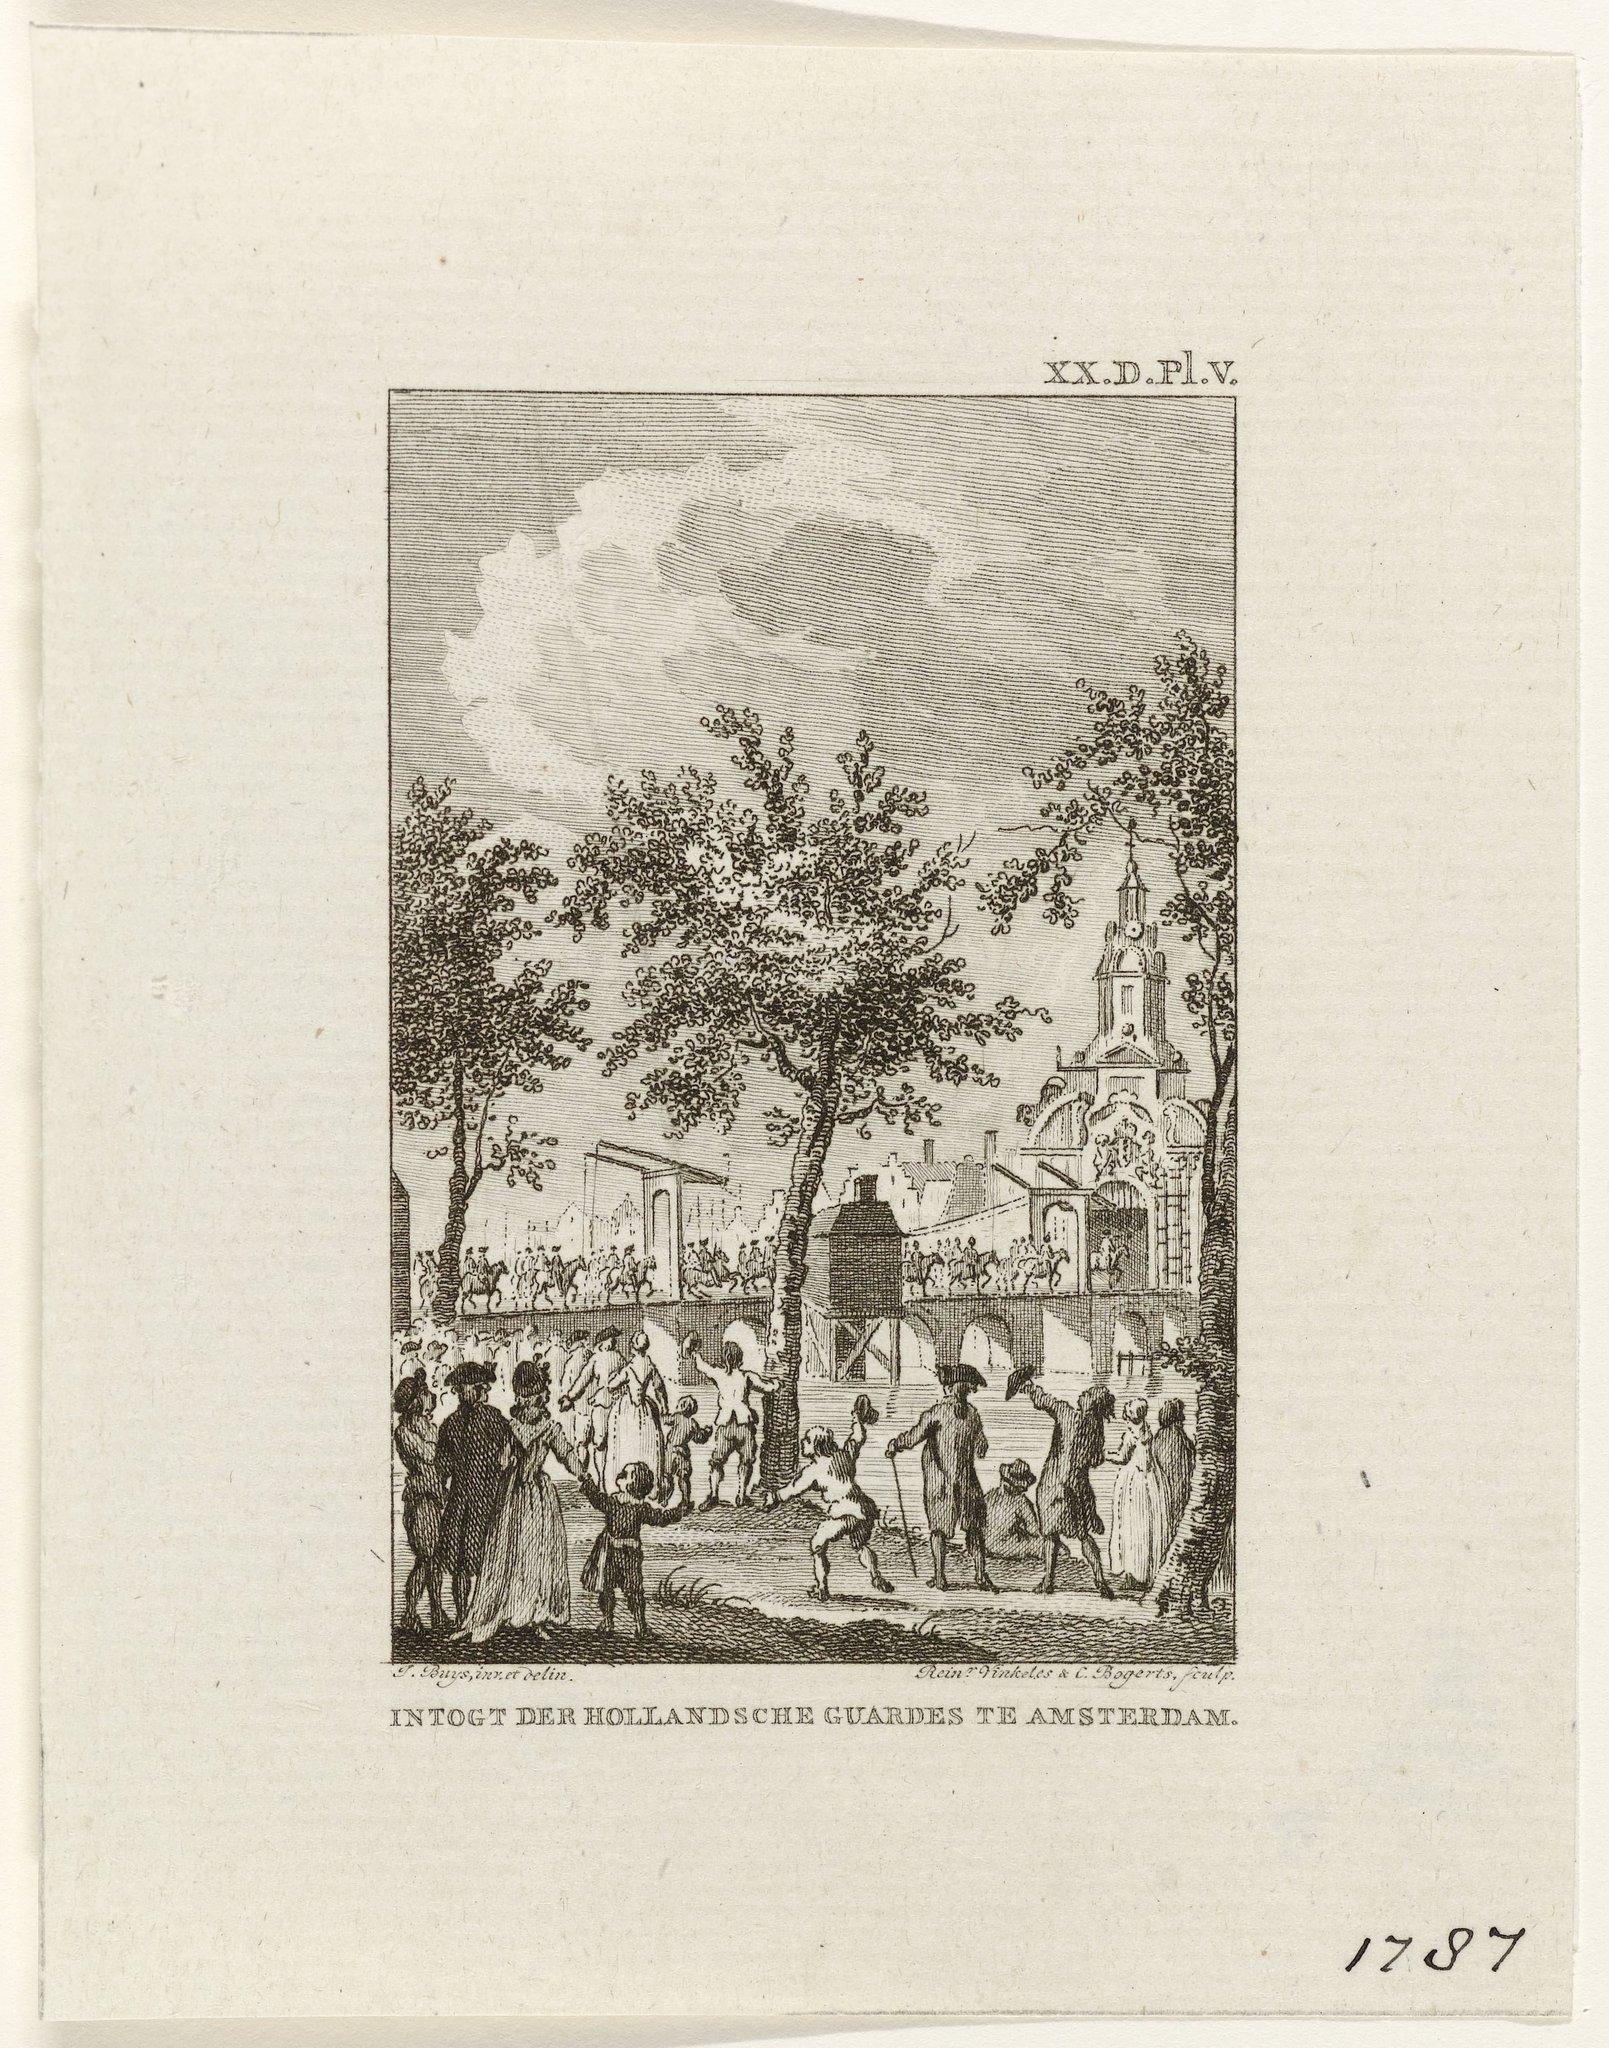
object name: history print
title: Intocht van de Hollandse Gardes te Amsterdam, 1787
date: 1787-1795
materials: paper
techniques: etching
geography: northern netherlands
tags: march into the conquered place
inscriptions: collector's mark: Lugt 2228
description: Gebruikt als illustratie in: J. Fokke, Geschiedenissen der Vereenigde Nederlanden voor de vaderlandsche jeugd, Johannes Allart, Amsterdam 1783-1795, 25 delen, dl. 20, pl. 5.